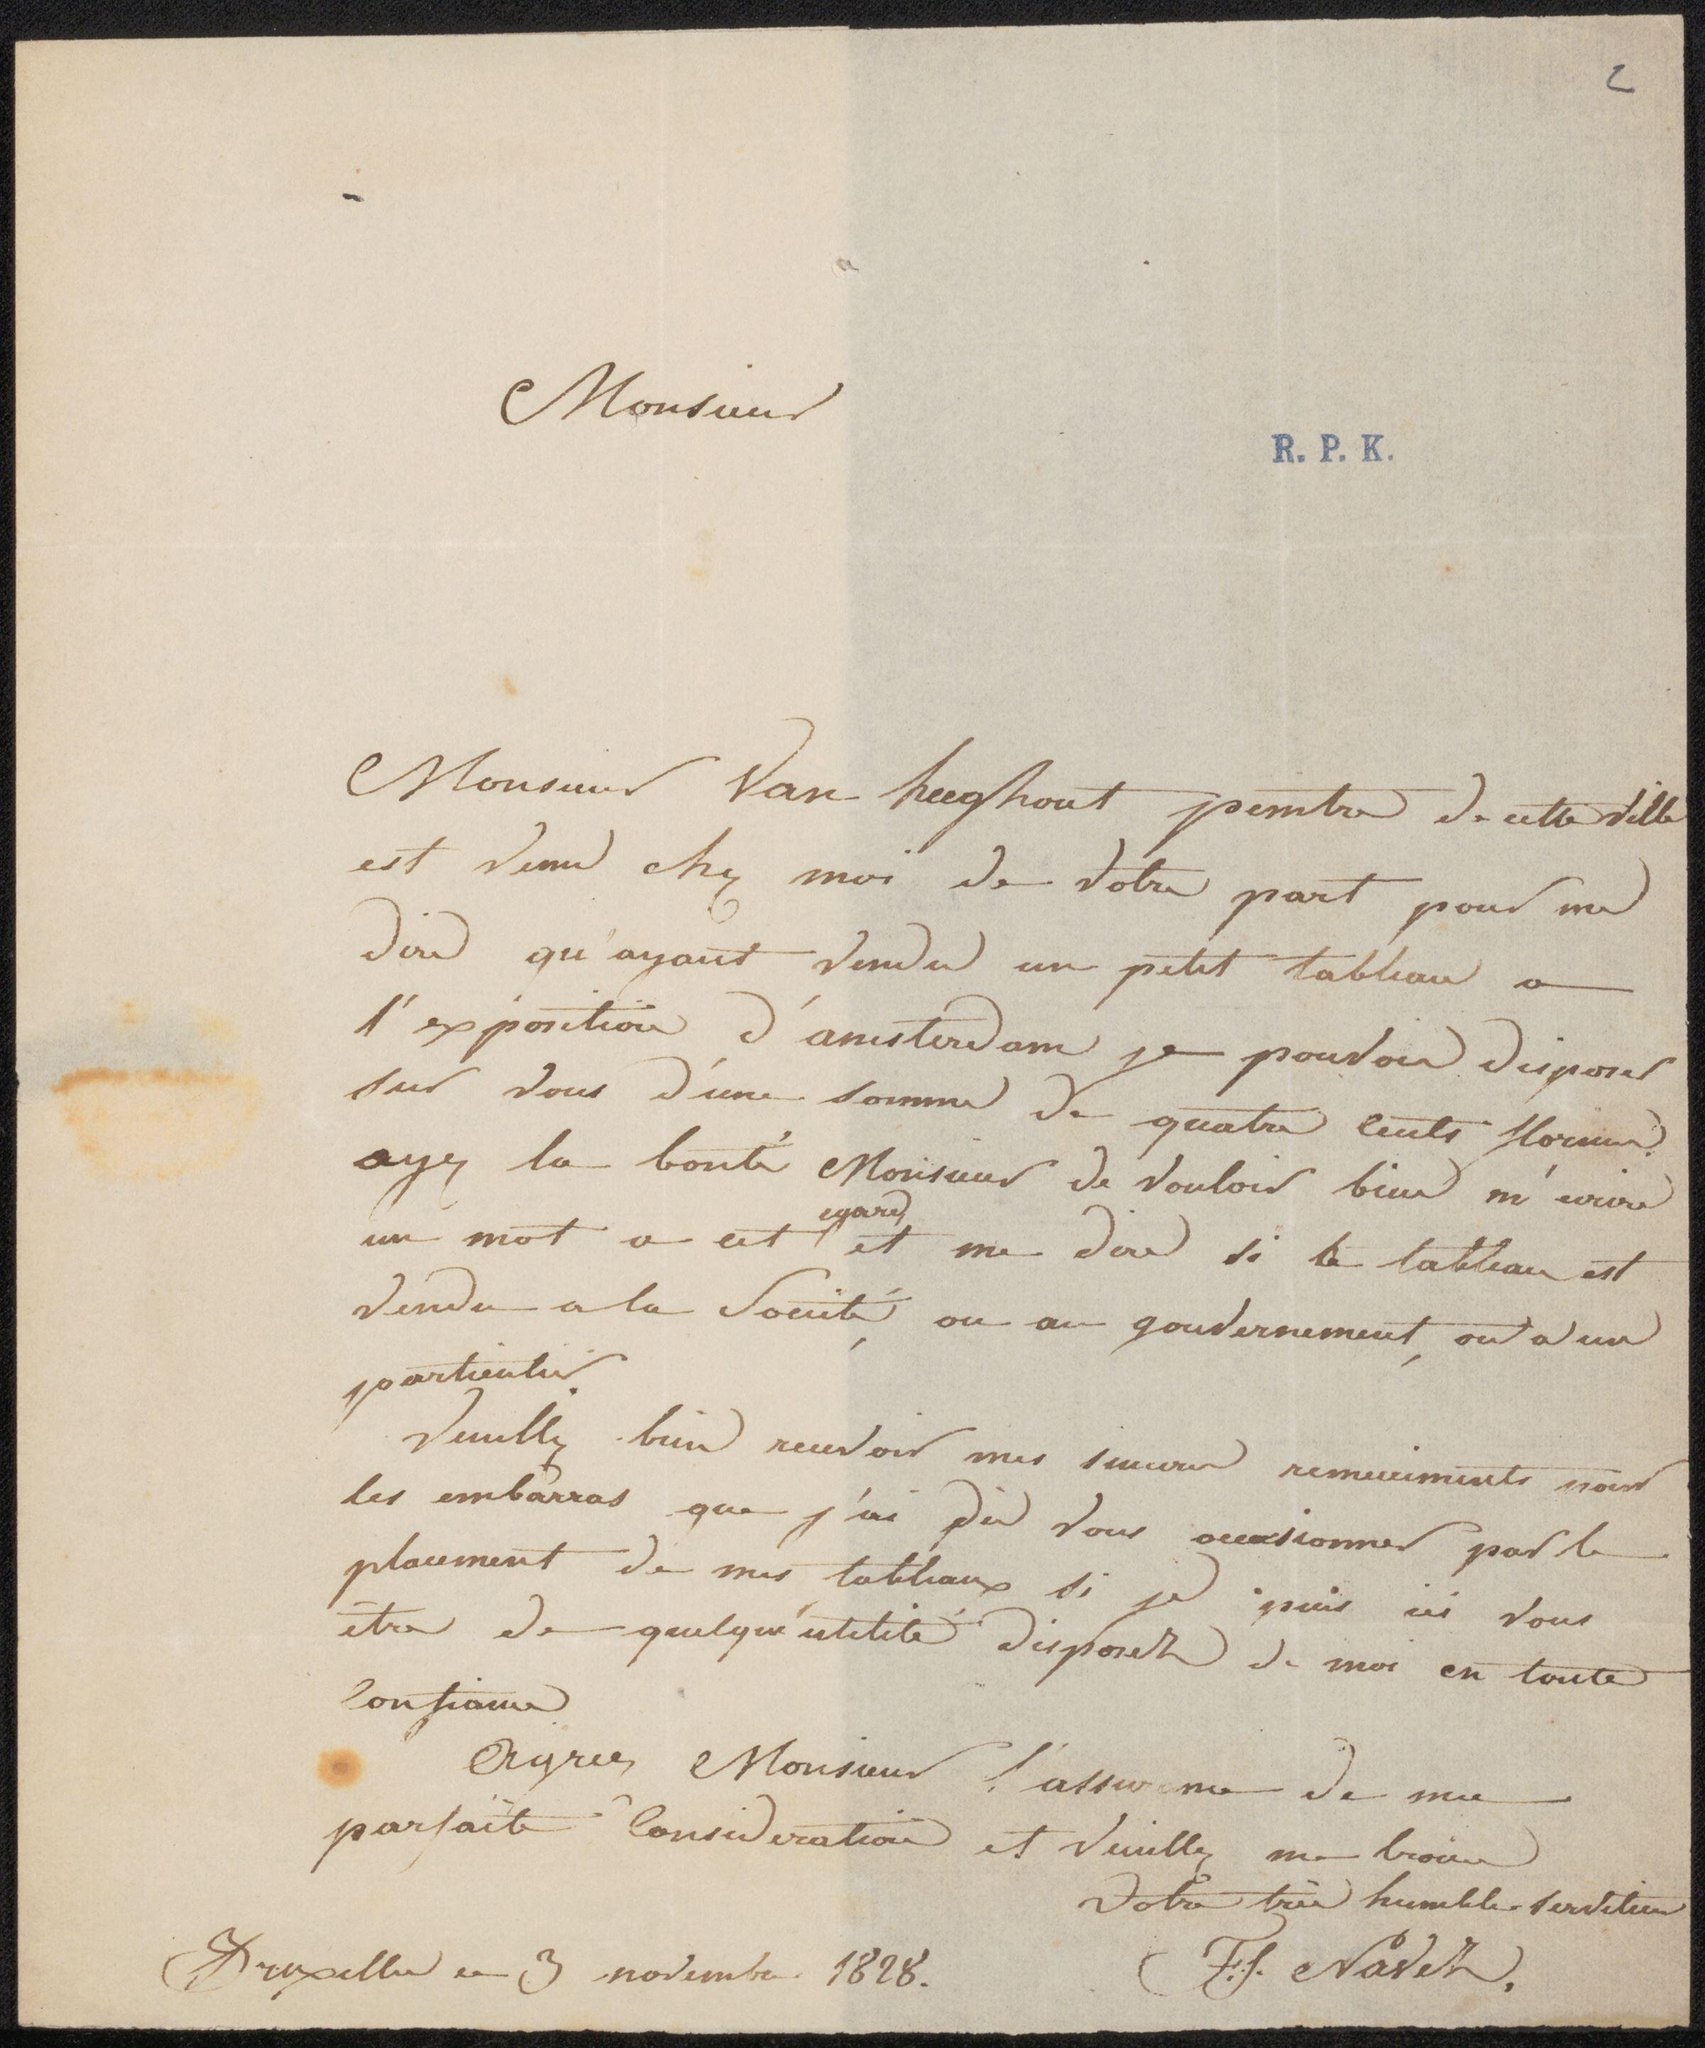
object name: letter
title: Brief aan anoniem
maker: françois joseph navez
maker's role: draughtsman, painter, print maker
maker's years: 1787-1869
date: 1828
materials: ink, paper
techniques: pen, writing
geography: brussels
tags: art trade, art shop, painting (including book-illumination, miniature-painting), exhibition ~ art, money, amsterdam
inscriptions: collector's mark: Lugt 2233